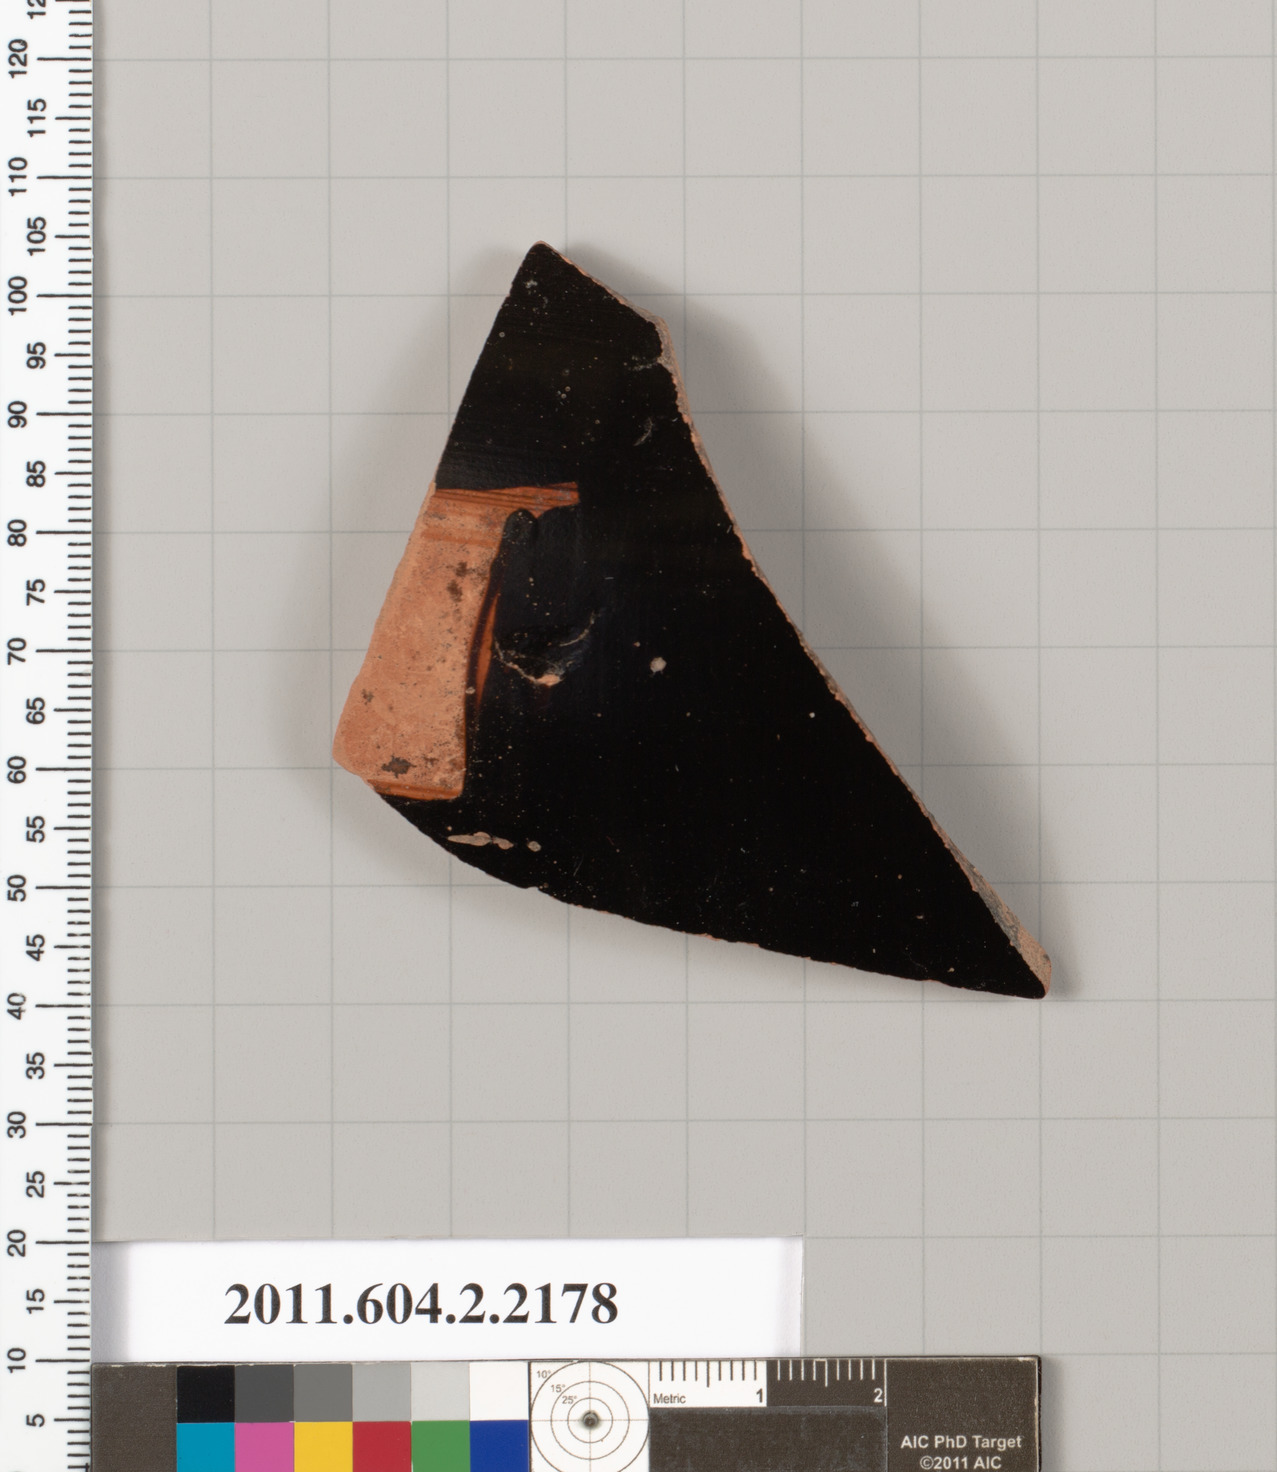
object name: pot fragment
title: Terracotta fragment of a pot; unglazed on the inside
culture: greek, attic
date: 450-426 BCE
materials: terracotta